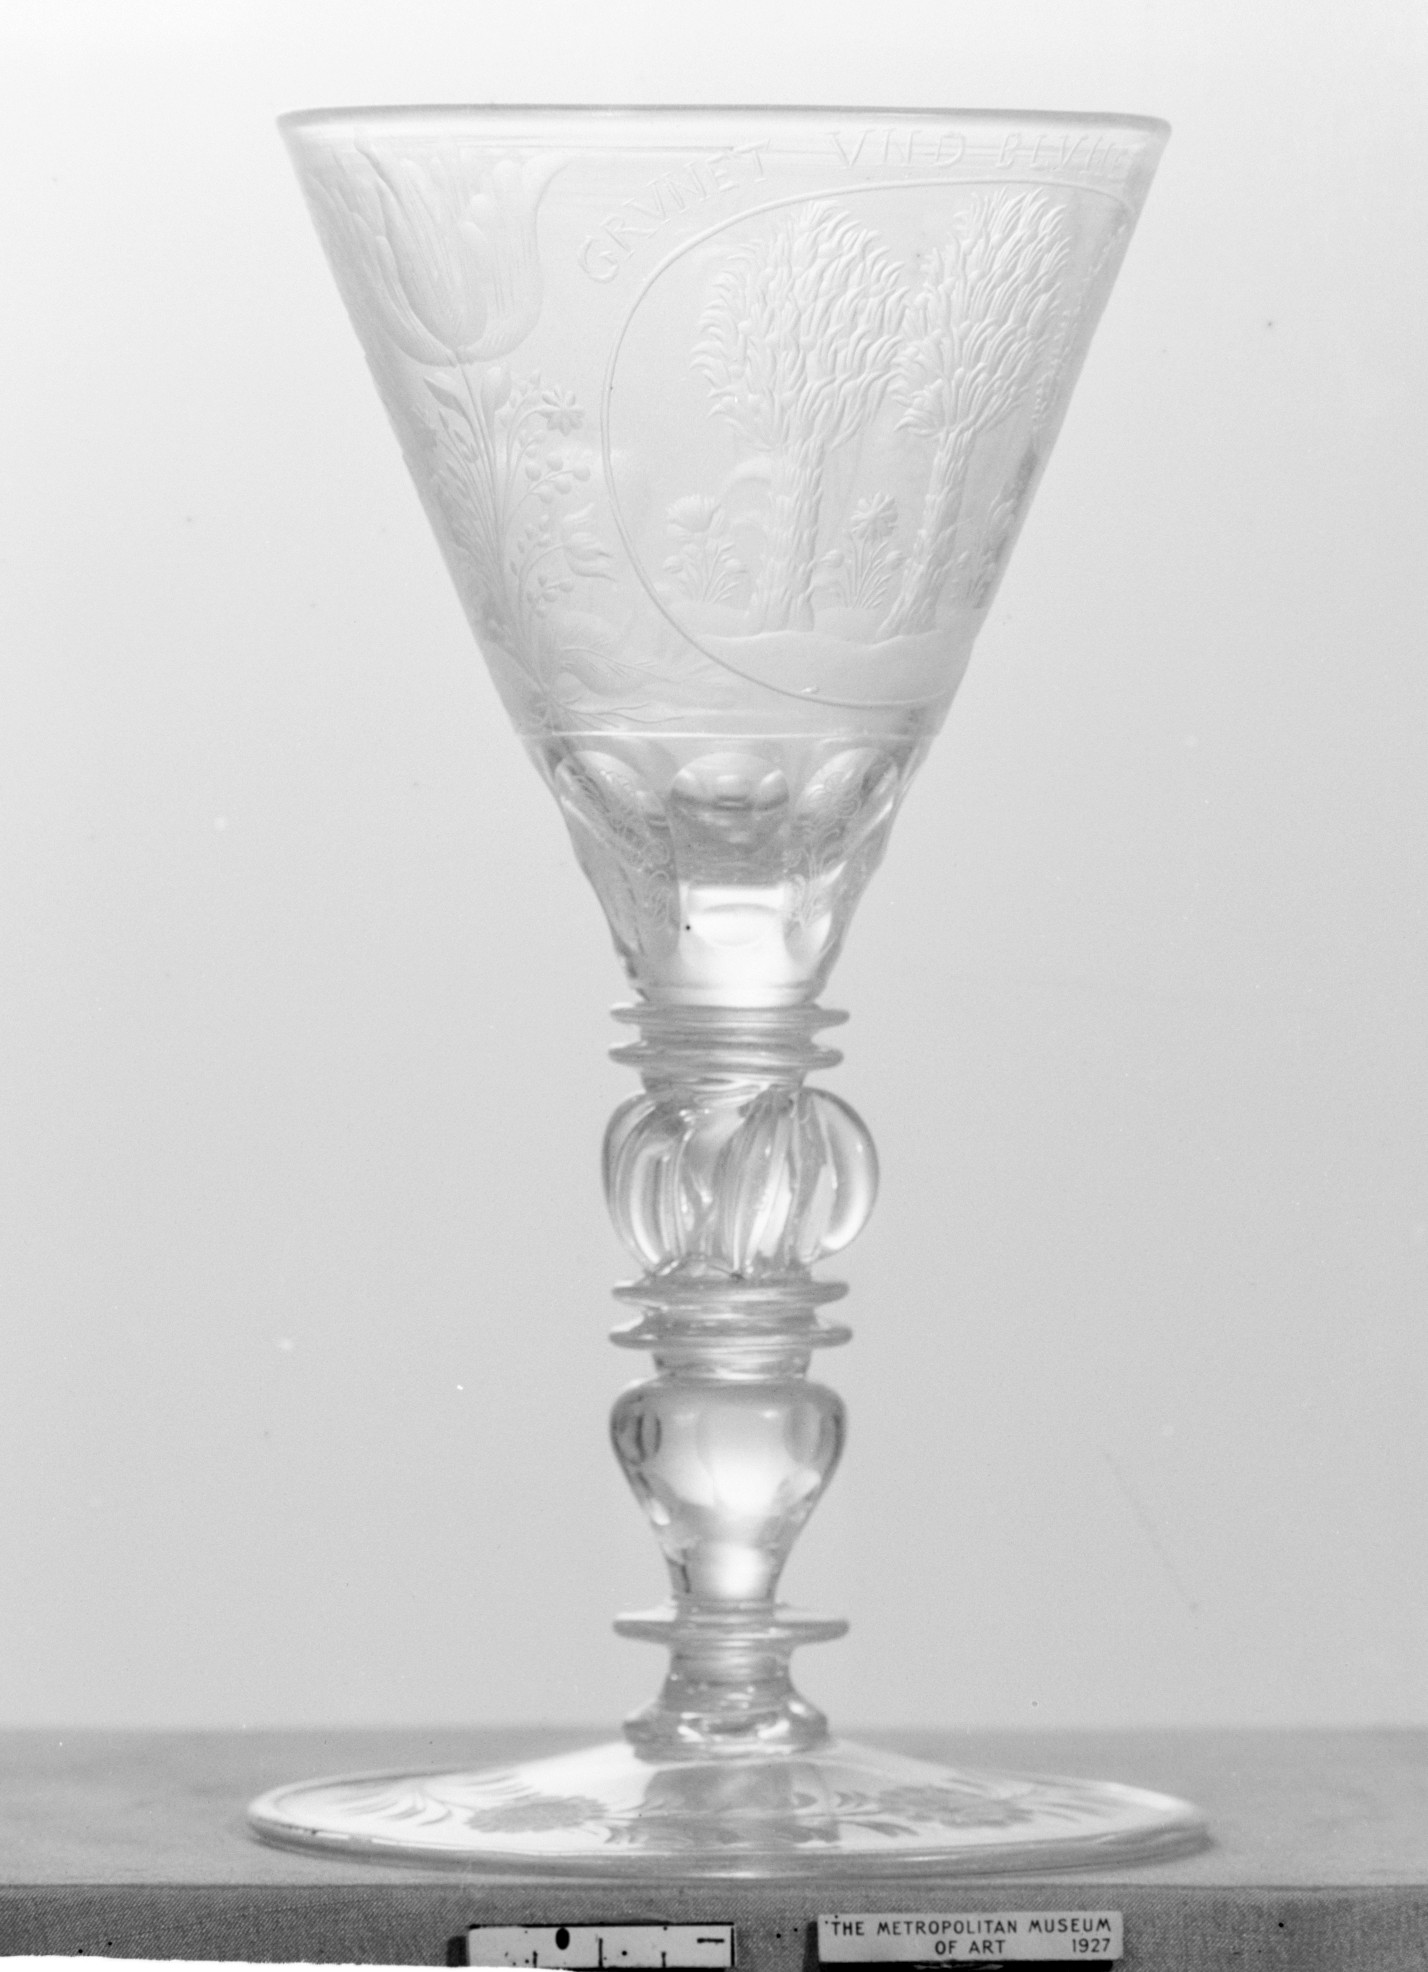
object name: wineglass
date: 1667-1700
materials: glass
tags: flowers